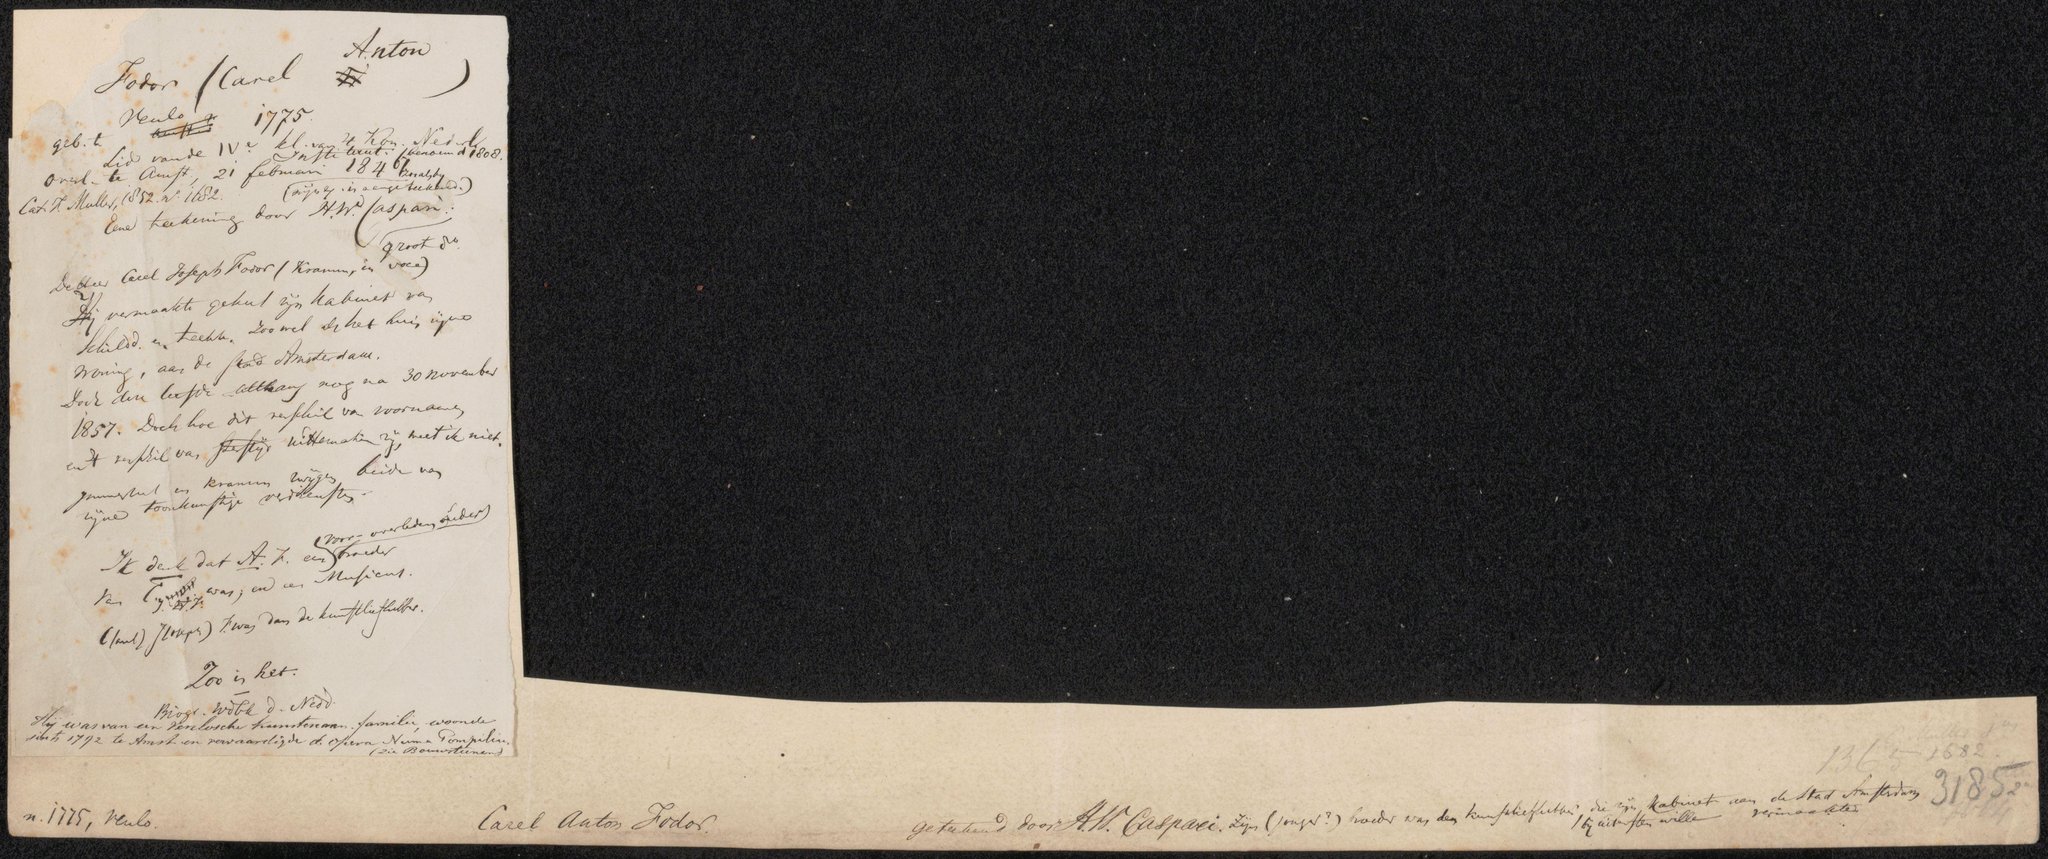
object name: aantekening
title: Aantekeningen over Carel Anton Fodor en Carl Joseph Fodor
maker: Anonymous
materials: ink, paper, pencil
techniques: pen, writing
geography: amsterdam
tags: carel anton fodor, carl joseph fodor, hendrik willem caspari, utrecht, print maker, draughtsman, christiaan kramm, drawing, historical persons (portraits and scenes from the life), amsterdam